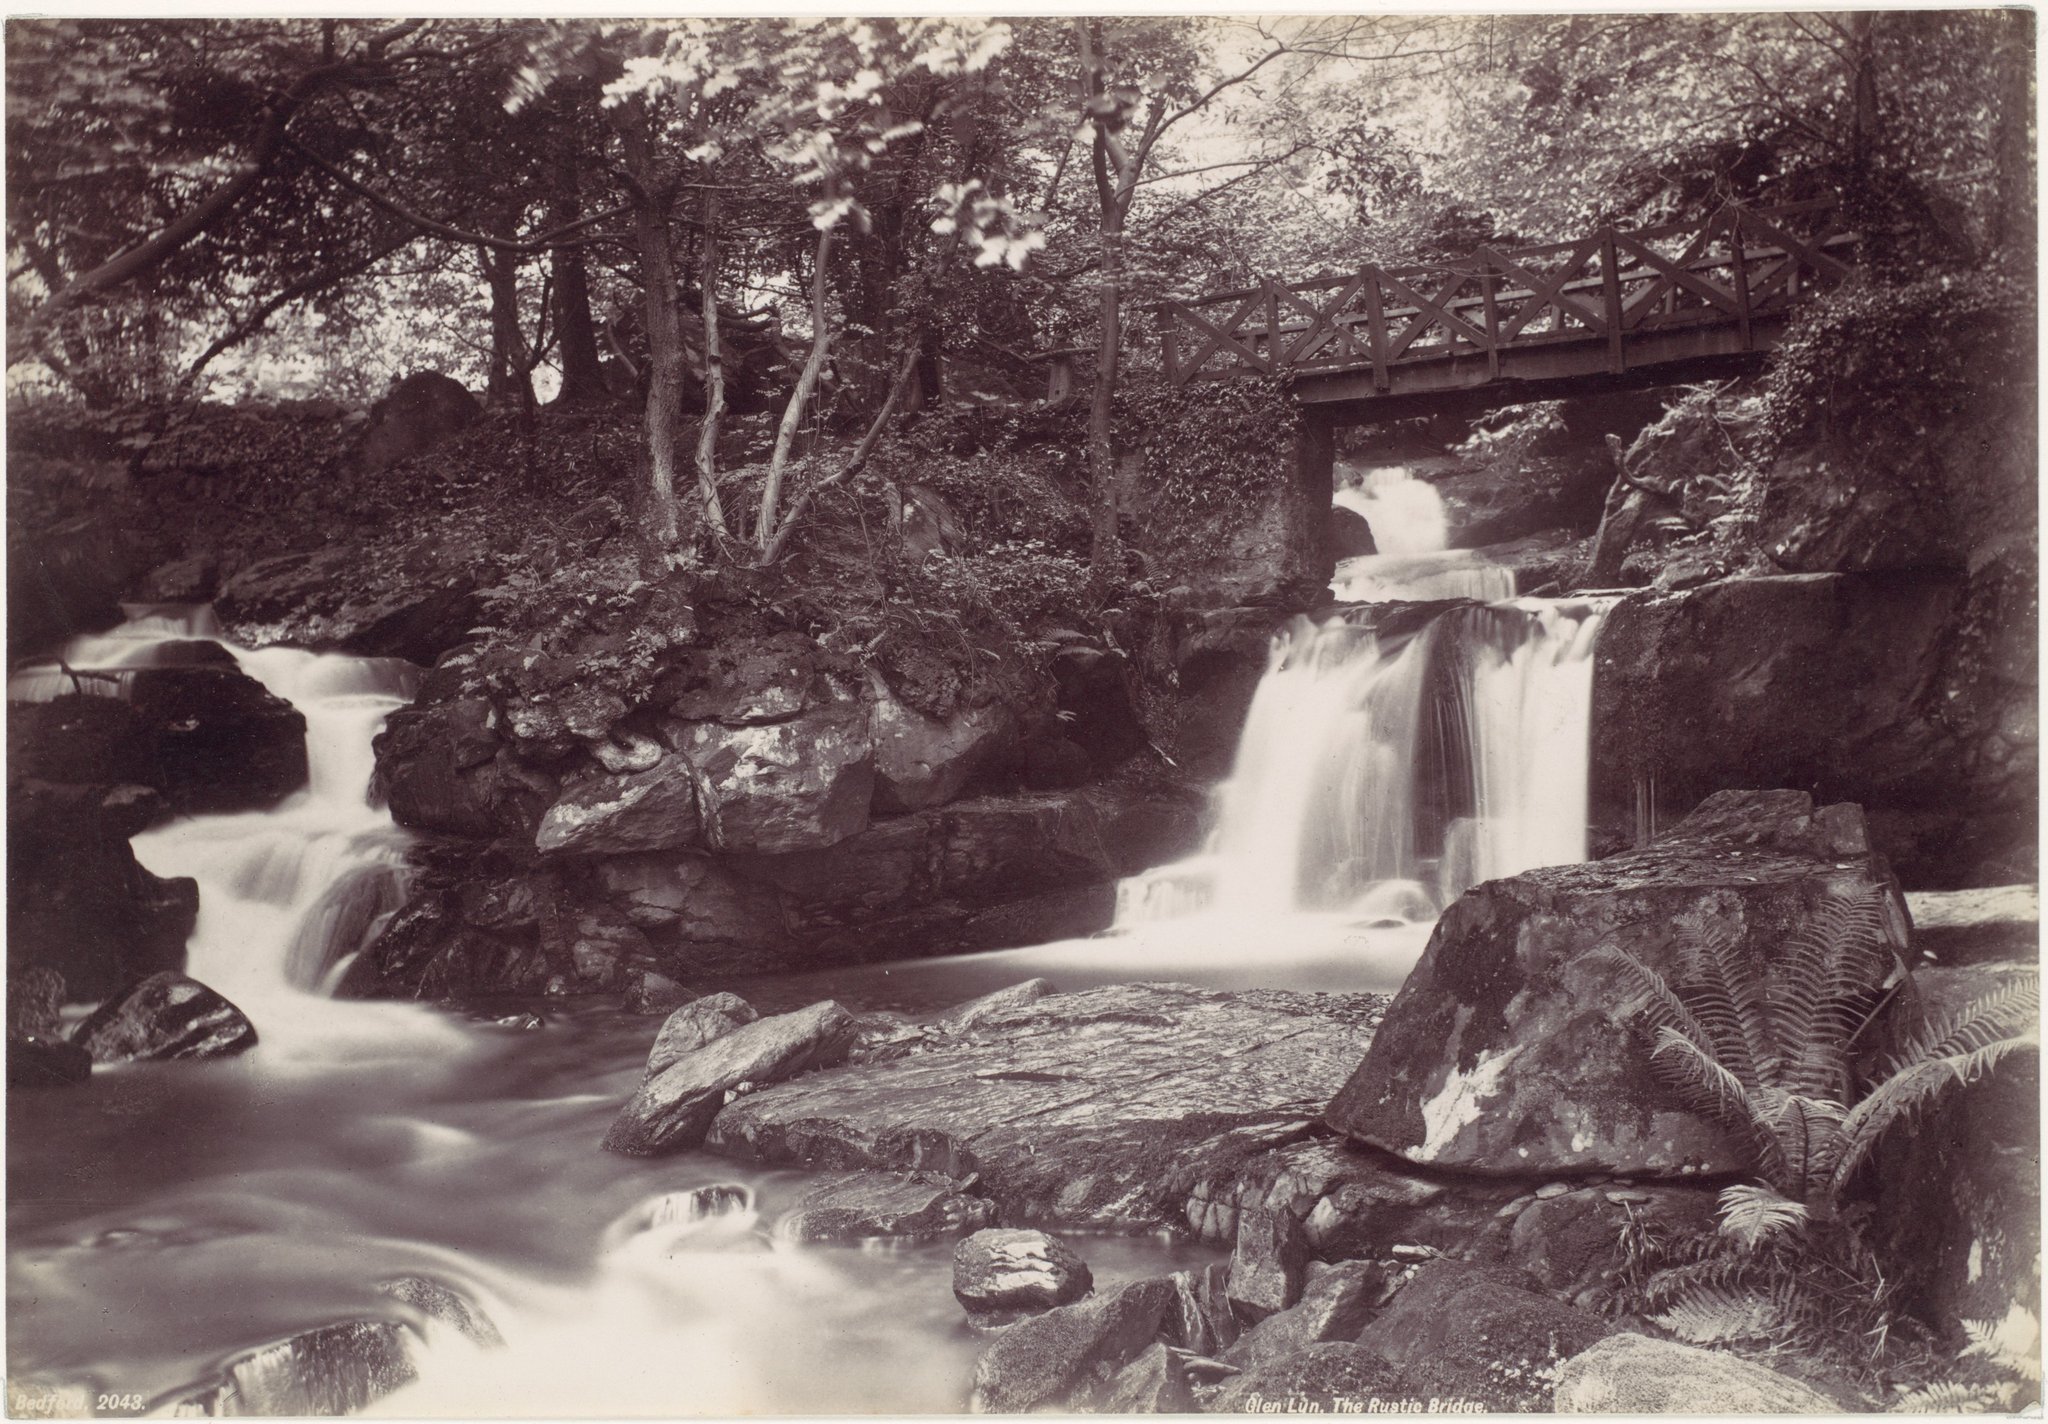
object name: photograph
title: Glen Lun. The Rustic Bridge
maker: francis bedford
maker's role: artist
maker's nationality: british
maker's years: 1816-1894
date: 1870-1879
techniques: albumen silver print, glass negative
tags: bridges,waterfalls